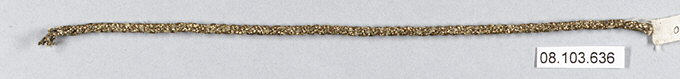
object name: cord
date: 1701-1900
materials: metal thread